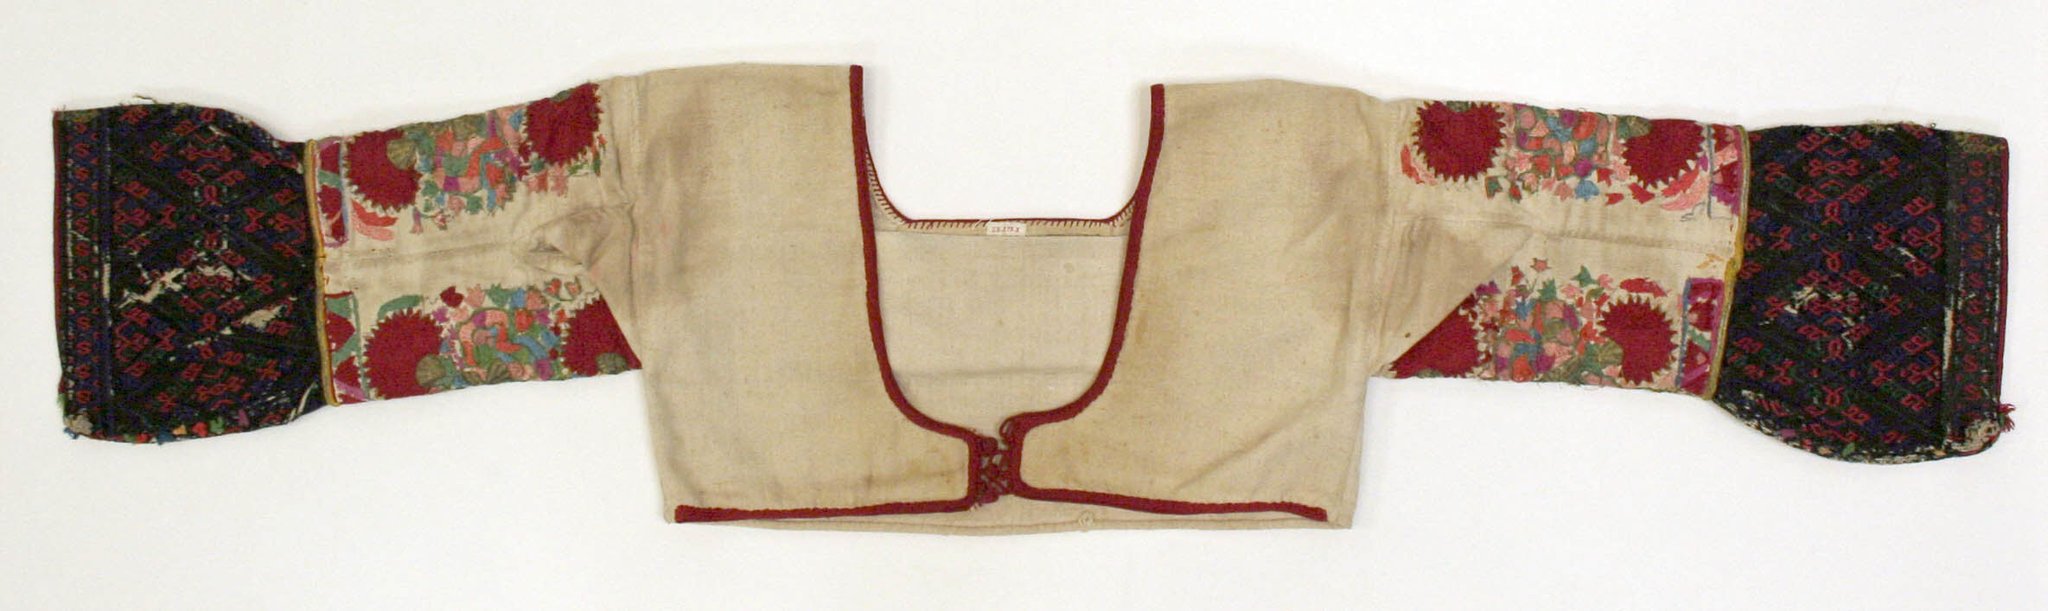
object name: jacket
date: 1701-1800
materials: cotton, silk